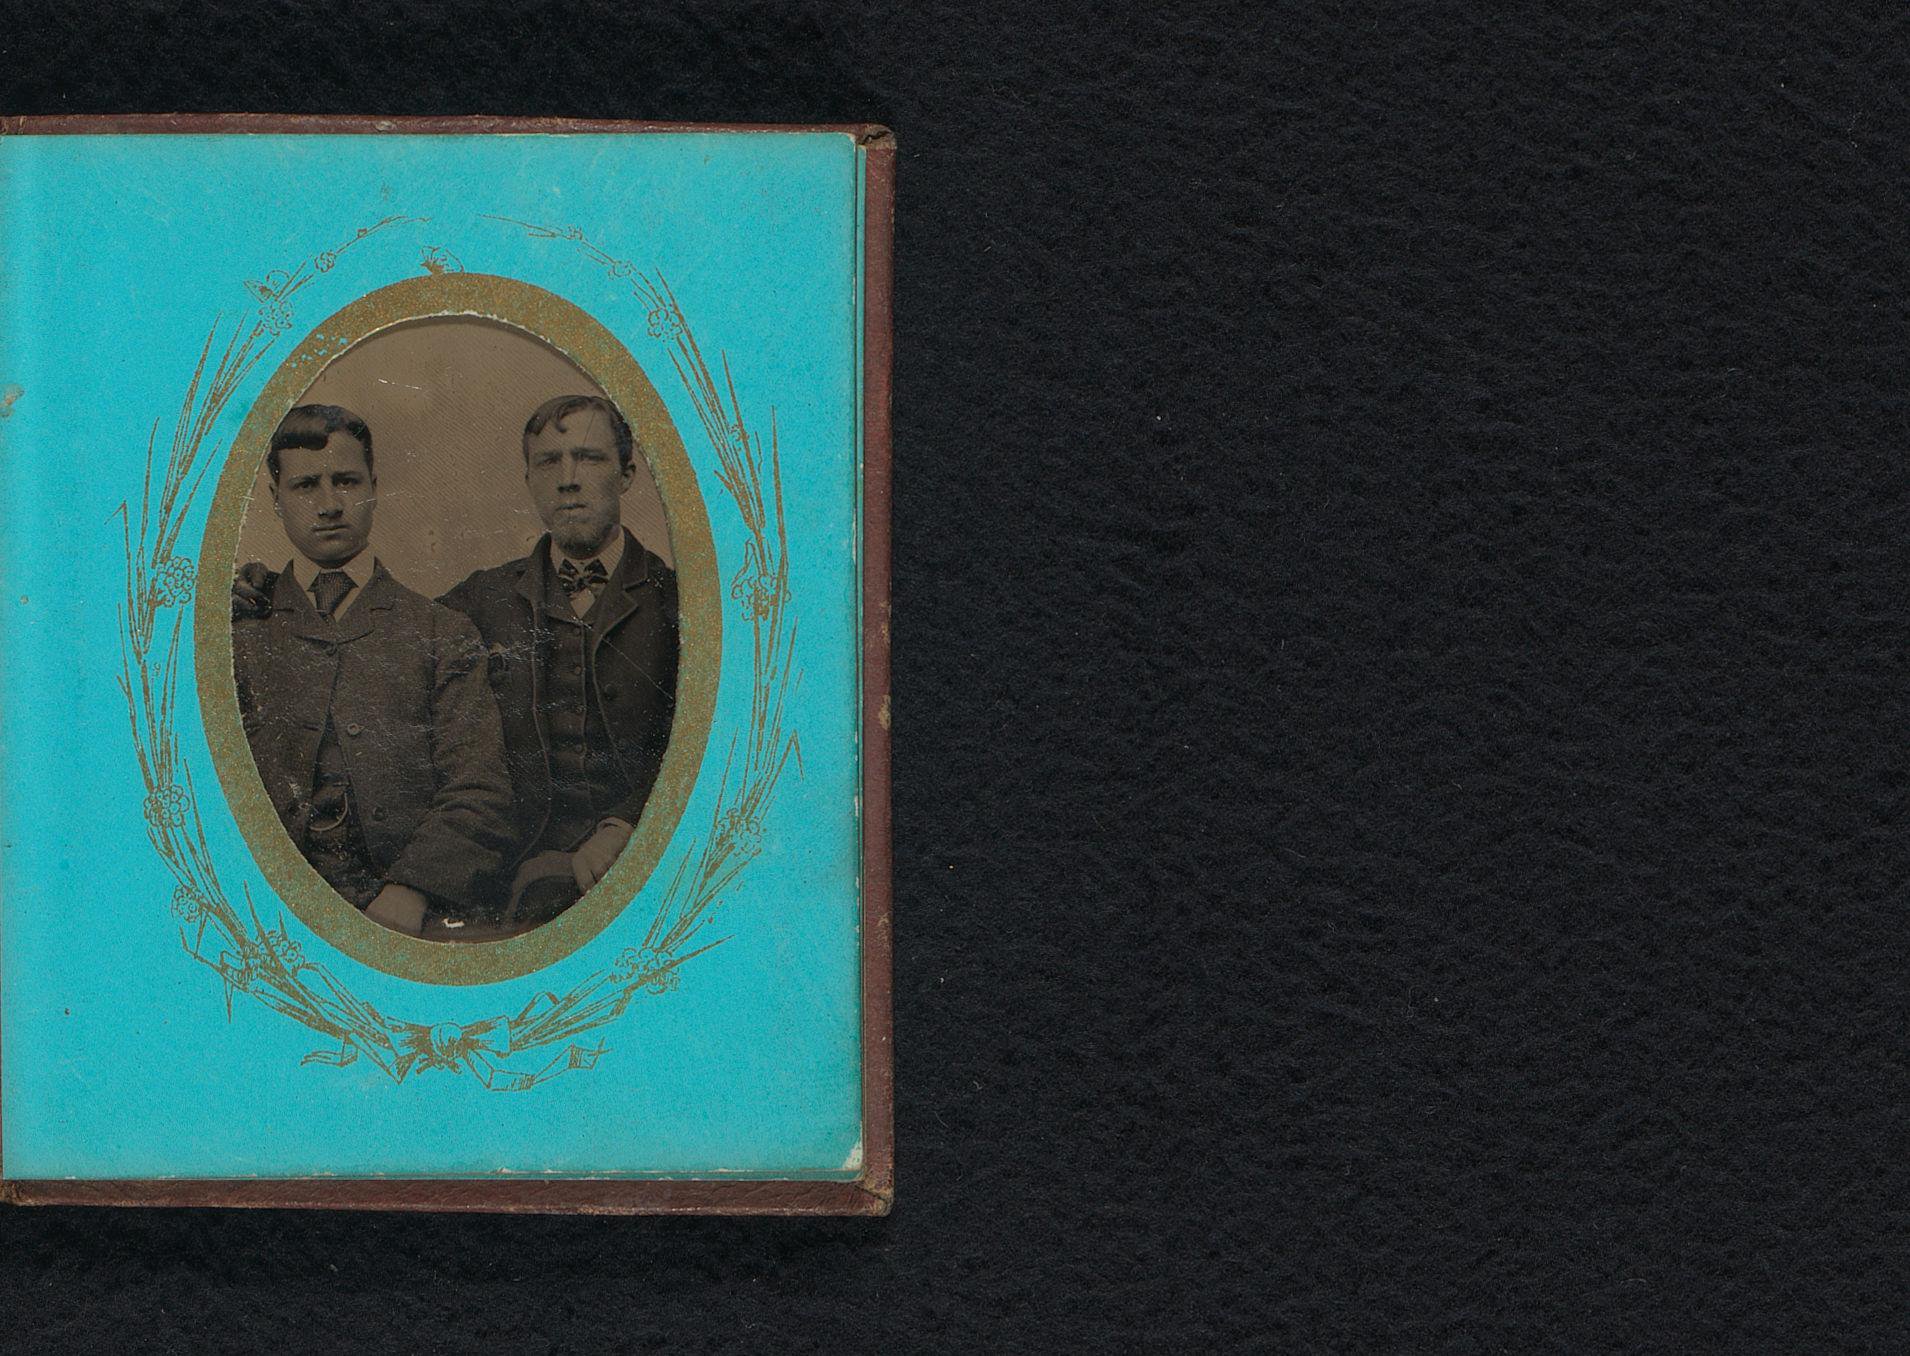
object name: album leaf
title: Portret van twee mannen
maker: Anonymous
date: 1880-1900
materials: iron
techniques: ferrotyping, hand coloring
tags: anonymous historical persons portrayed in a double portrait